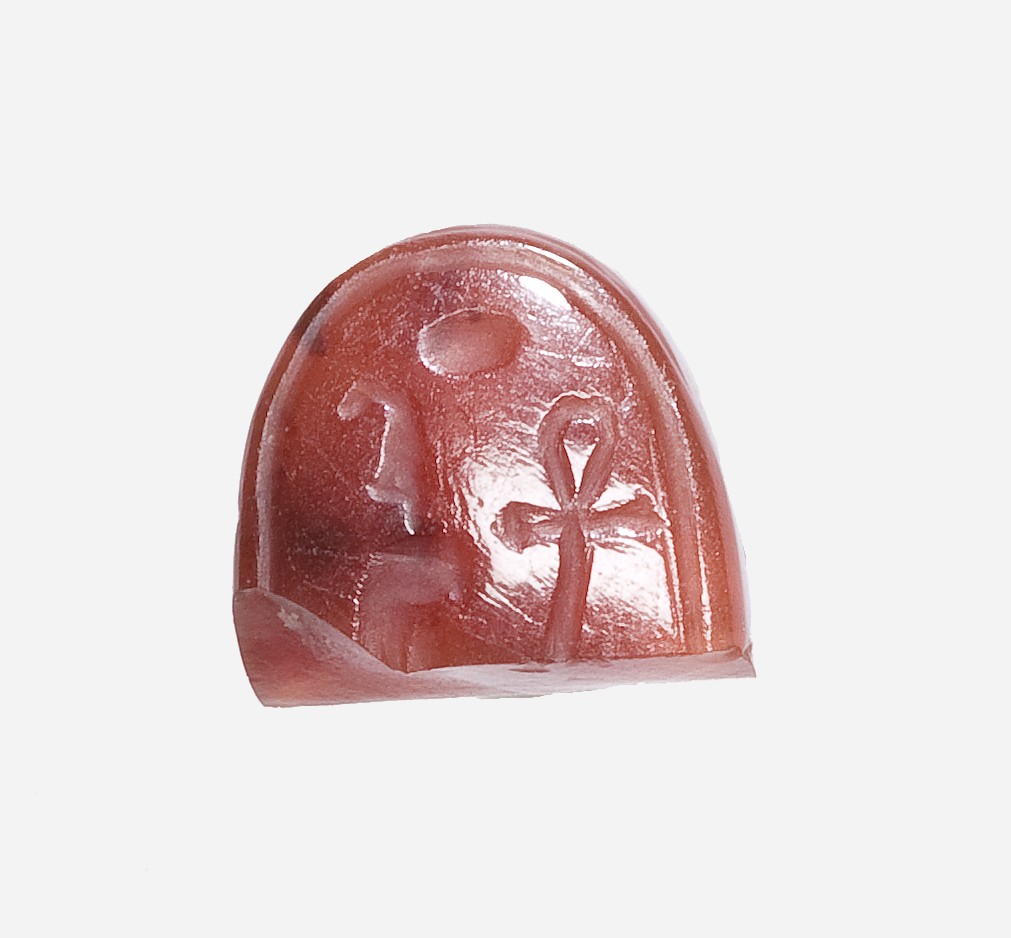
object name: ring fragment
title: Ring Fragment with Cartouche of Amenhotep III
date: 1390-1352 BCE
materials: gemstone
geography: egypt